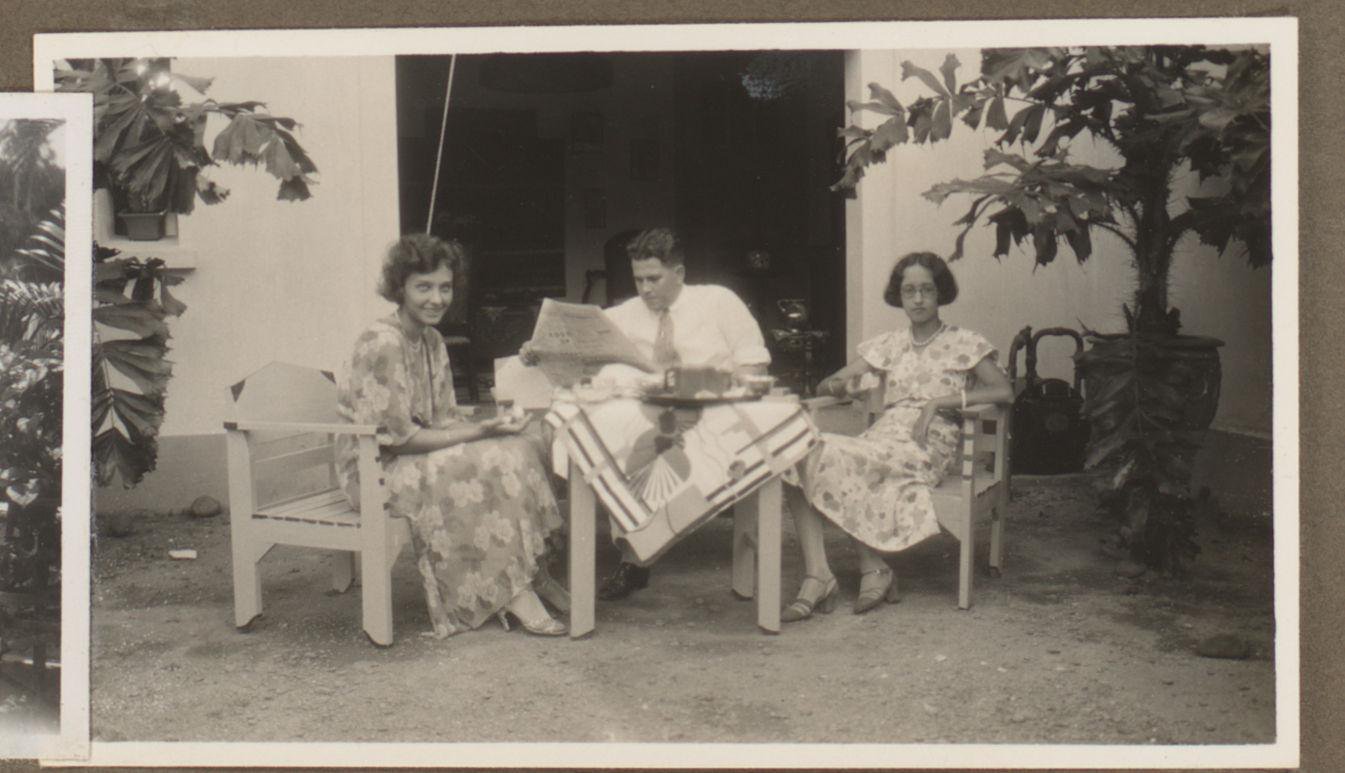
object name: album leaf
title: Gezelschap aan een tafel, Batavia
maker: Anonymous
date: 1932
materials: paper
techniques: gelatin silver print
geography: batavia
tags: amsterdam, reading, garden, batavia